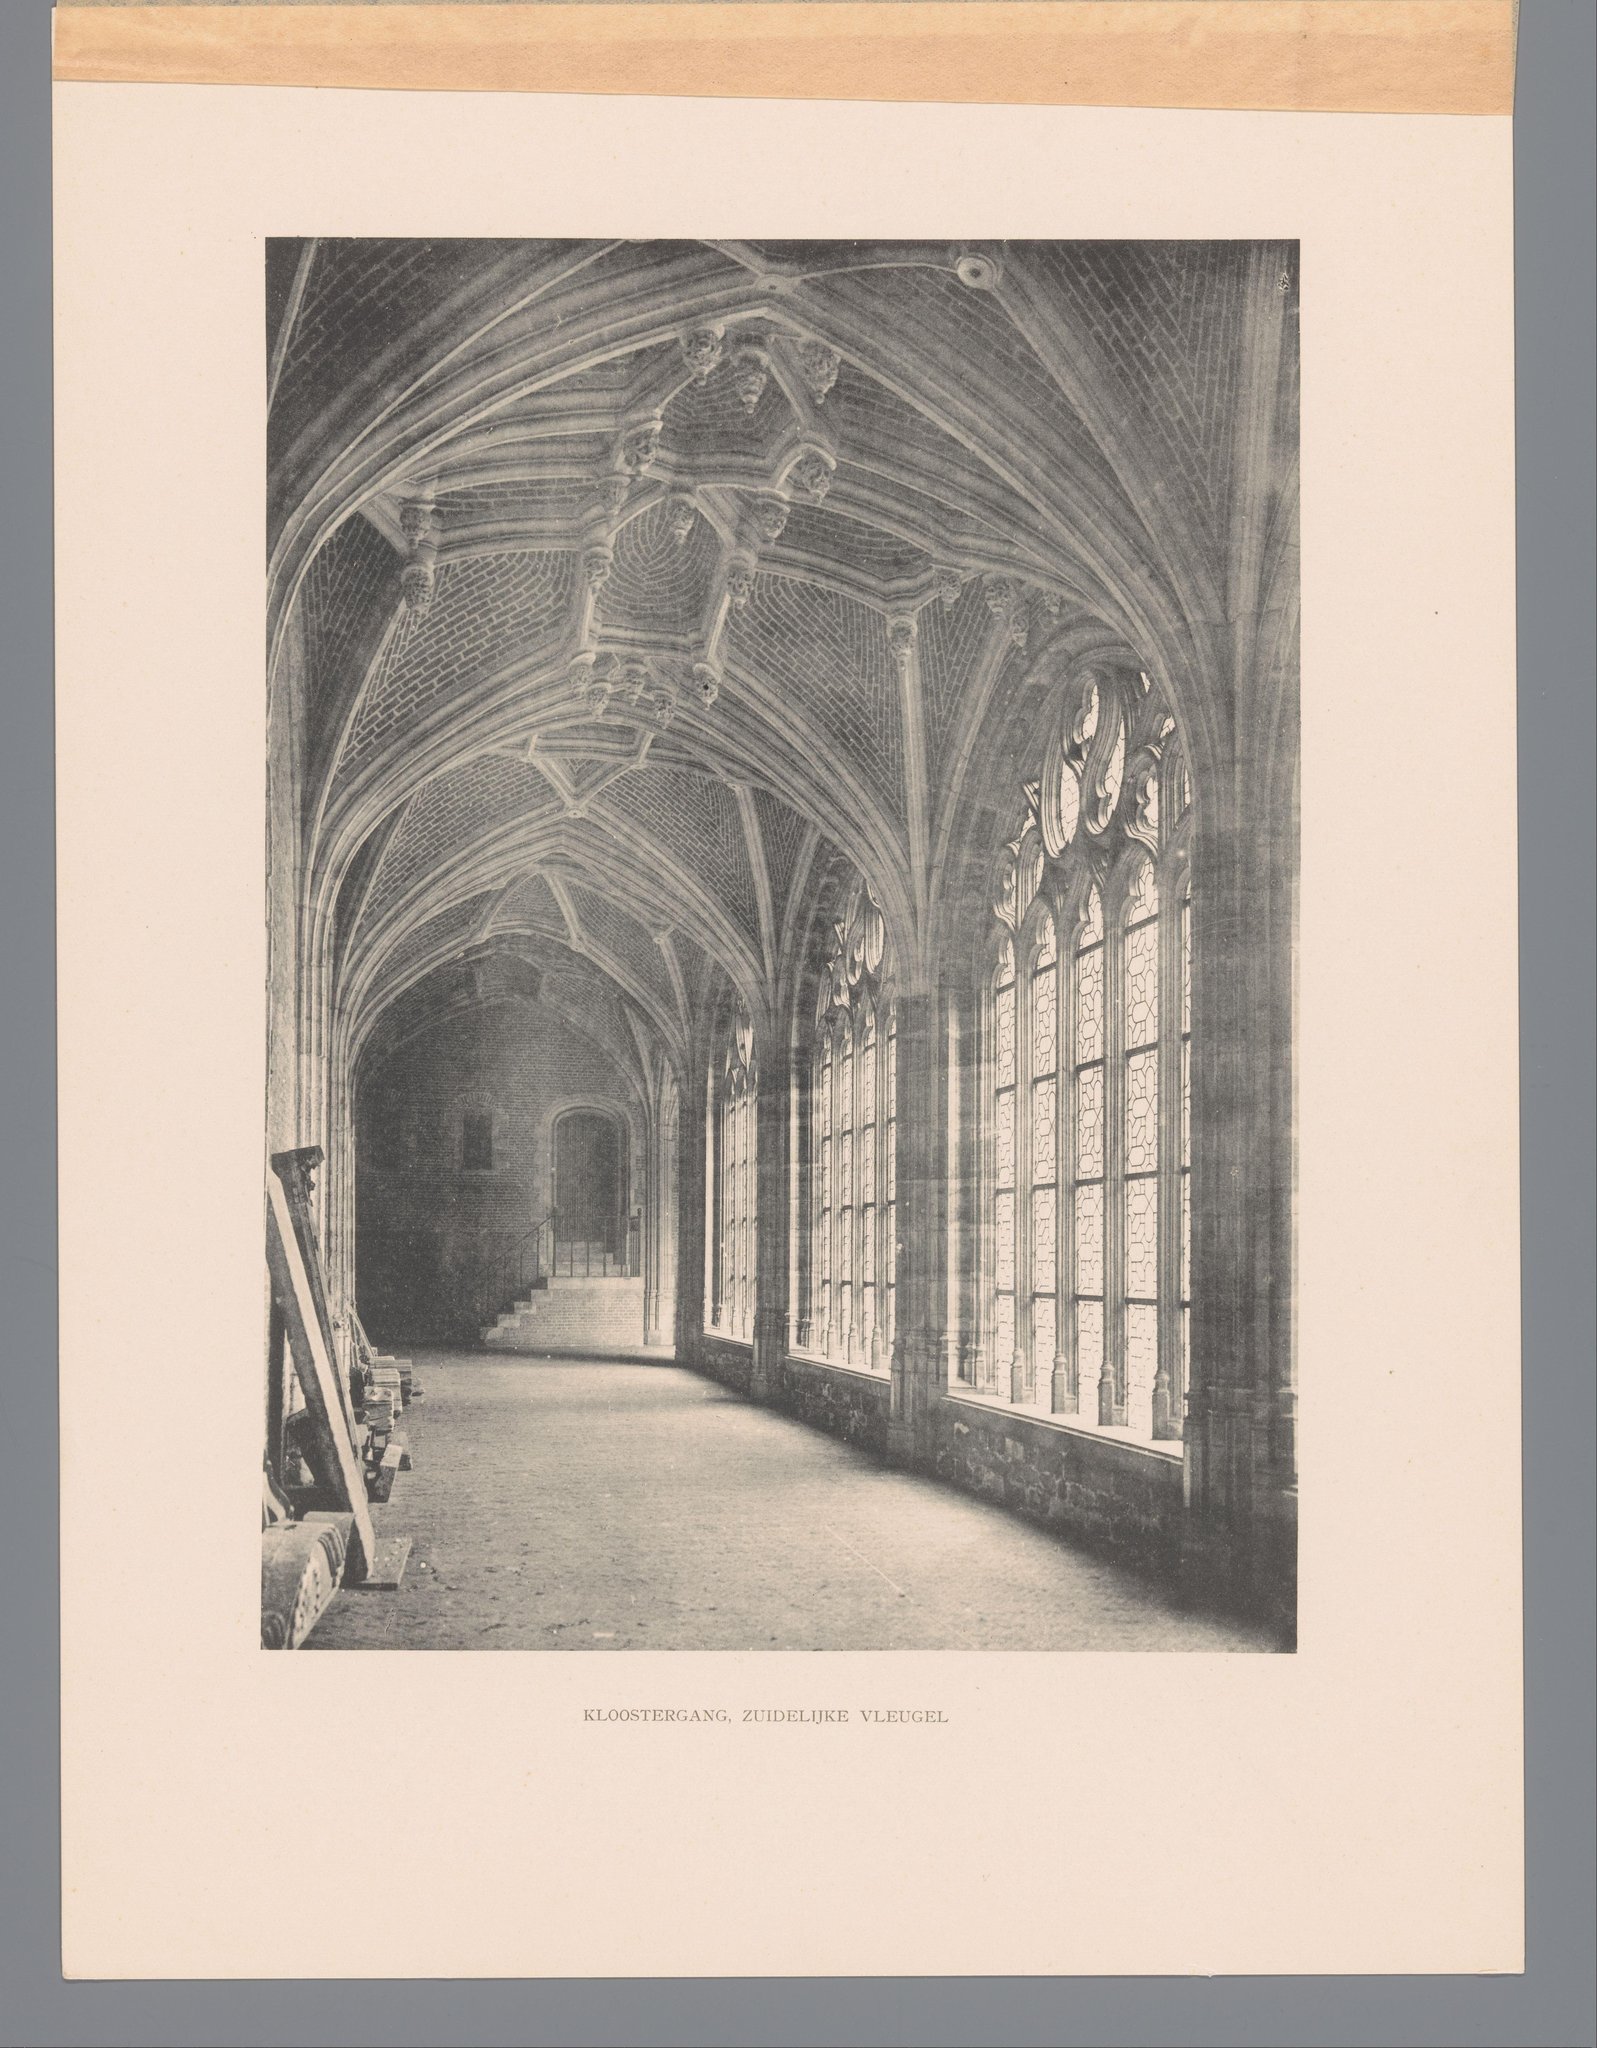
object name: photomechanical print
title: Gezicht op de zuidelijke vleugel van de kloostergang van de Abdij te Middelburg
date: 1900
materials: paper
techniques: photograph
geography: middelburg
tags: corridor, abbey, monastery, convent ~ roman catholic church, cloisters ~ monastery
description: Deze afdruk maakt deel uit van een omslag met acht lichtdrukken.